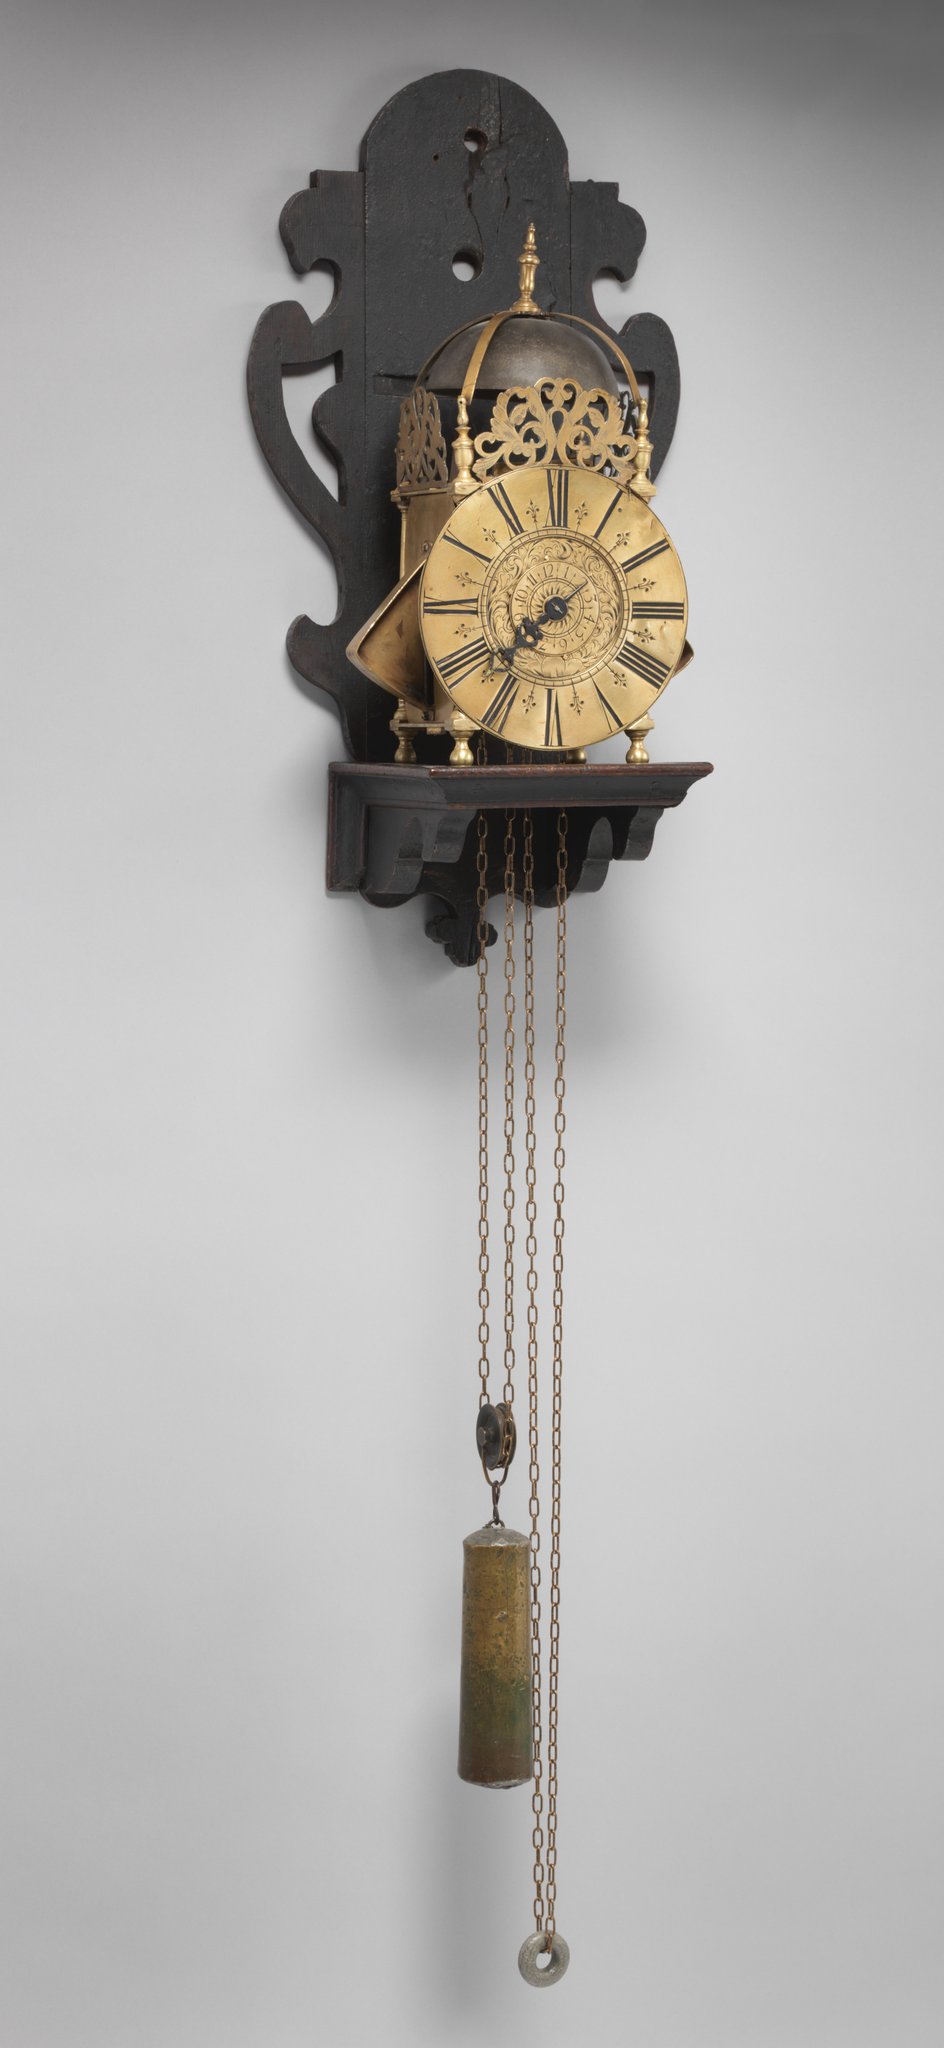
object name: lantern clock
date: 1685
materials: brass